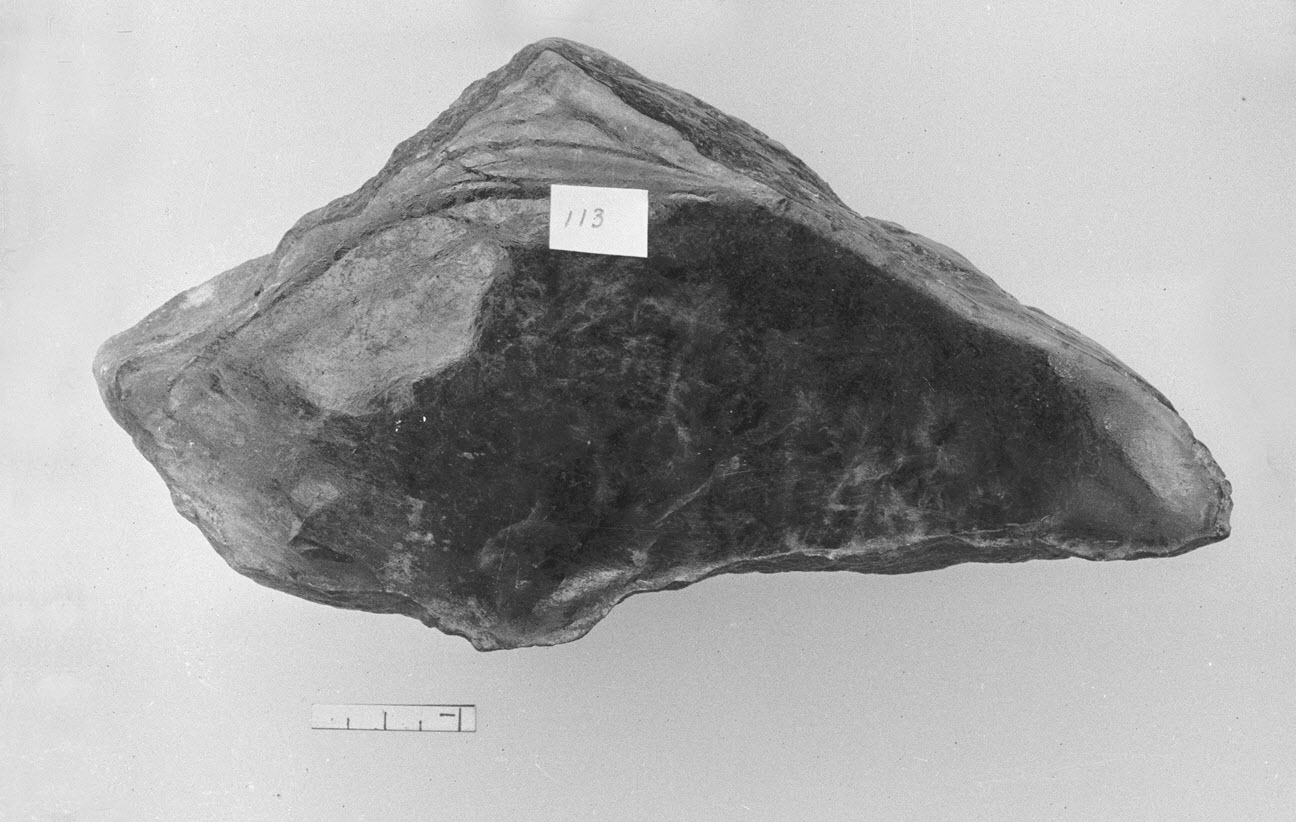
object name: fragment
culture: russian, siberia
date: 1902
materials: jade